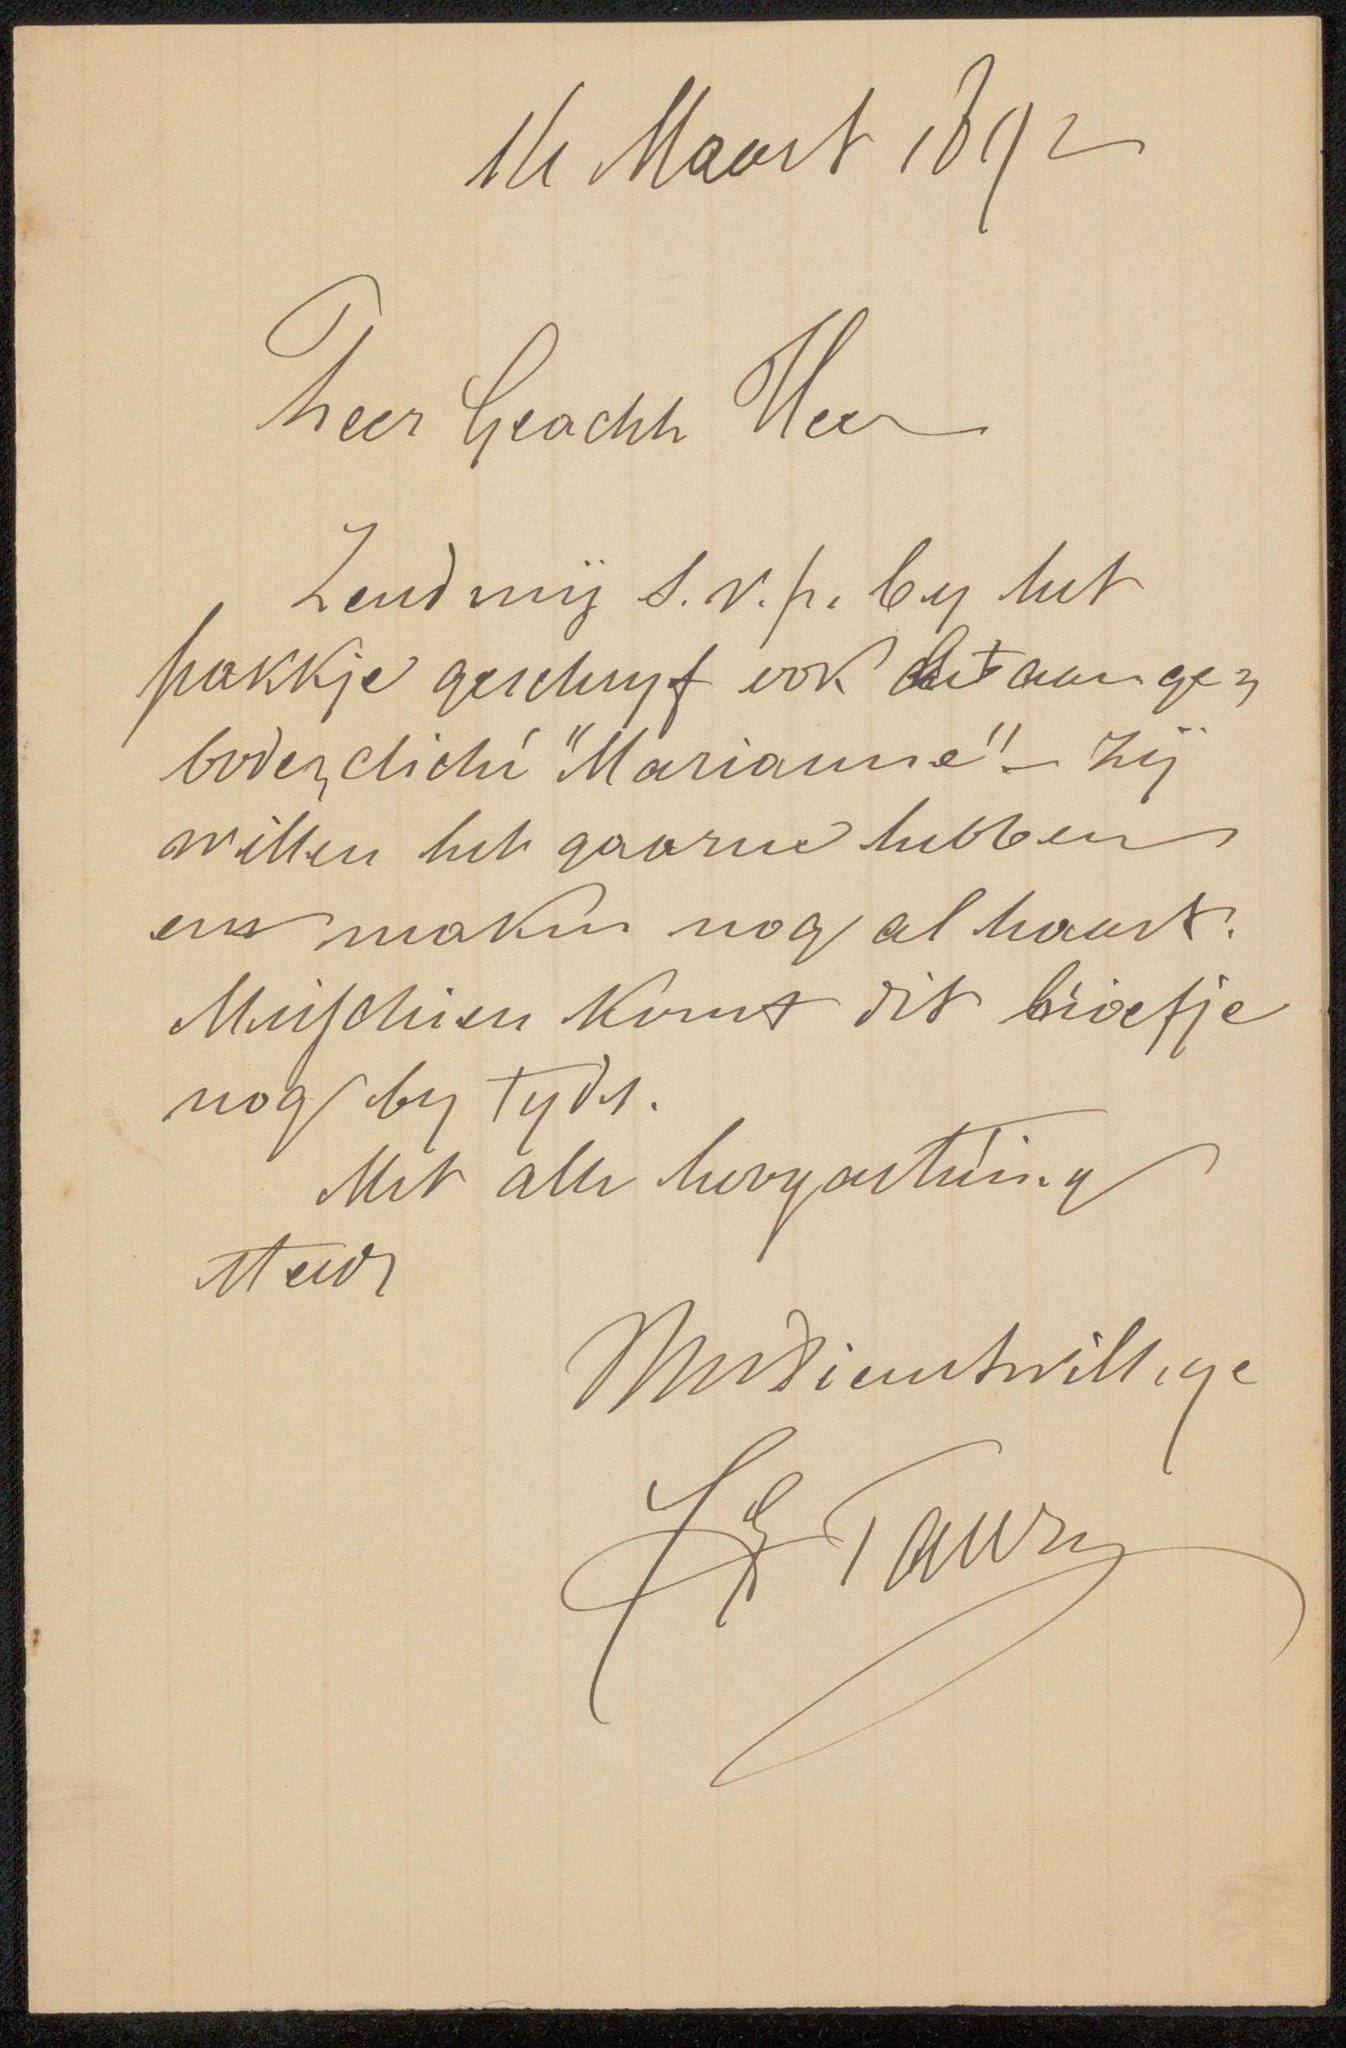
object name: letter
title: Brief aan Philip Zilcken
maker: edouard taurel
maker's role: draughtsman, print maker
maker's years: 1824-1892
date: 1892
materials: ink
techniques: pen, writing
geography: amsterdam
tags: the hague, painter, draughtsman, philip zilcken, printed matter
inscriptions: collector's mark: ‘RPK’